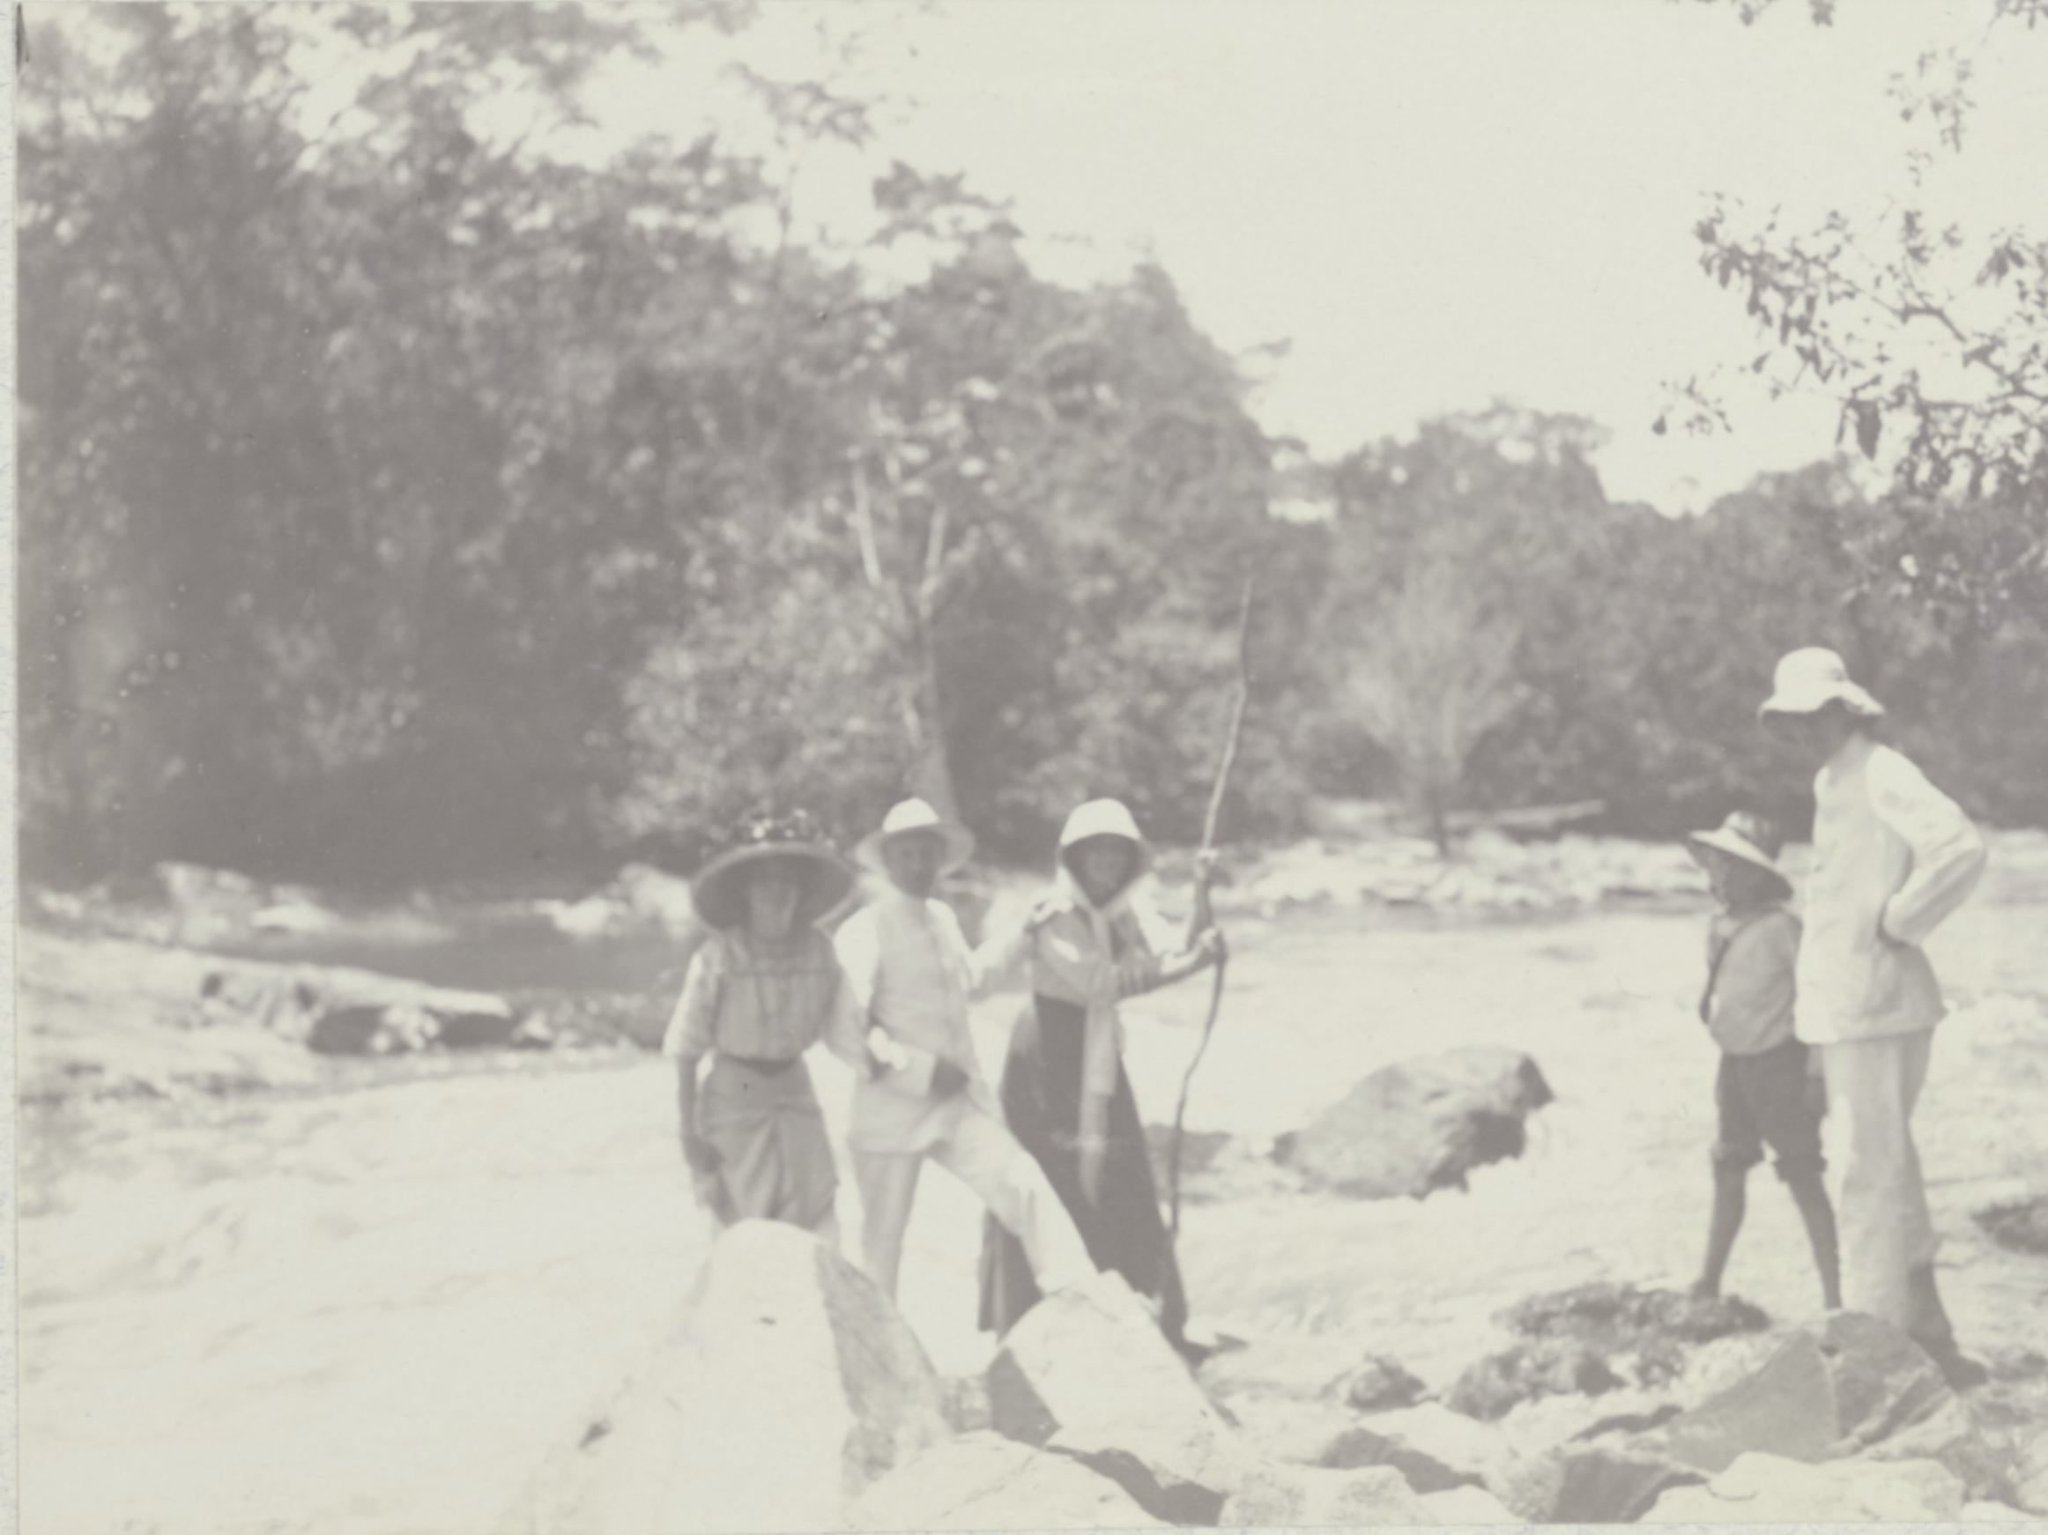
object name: photograph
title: Bij de rivier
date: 1909-1911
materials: photographic support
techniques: photography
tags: andries augustus boom, landscapes in tropical and sub-tropical regions, suriname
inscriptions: inscription: ‘Sept. 11’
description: Een groep mannen en vrouwen, waaronder Andries Boom, aan een rivieroever van de Sarakreek in Suriname, september 1911. Onderdeel van het fotoalbum van de familie Boom-Gonggrijp in Suriname en Curaçao.